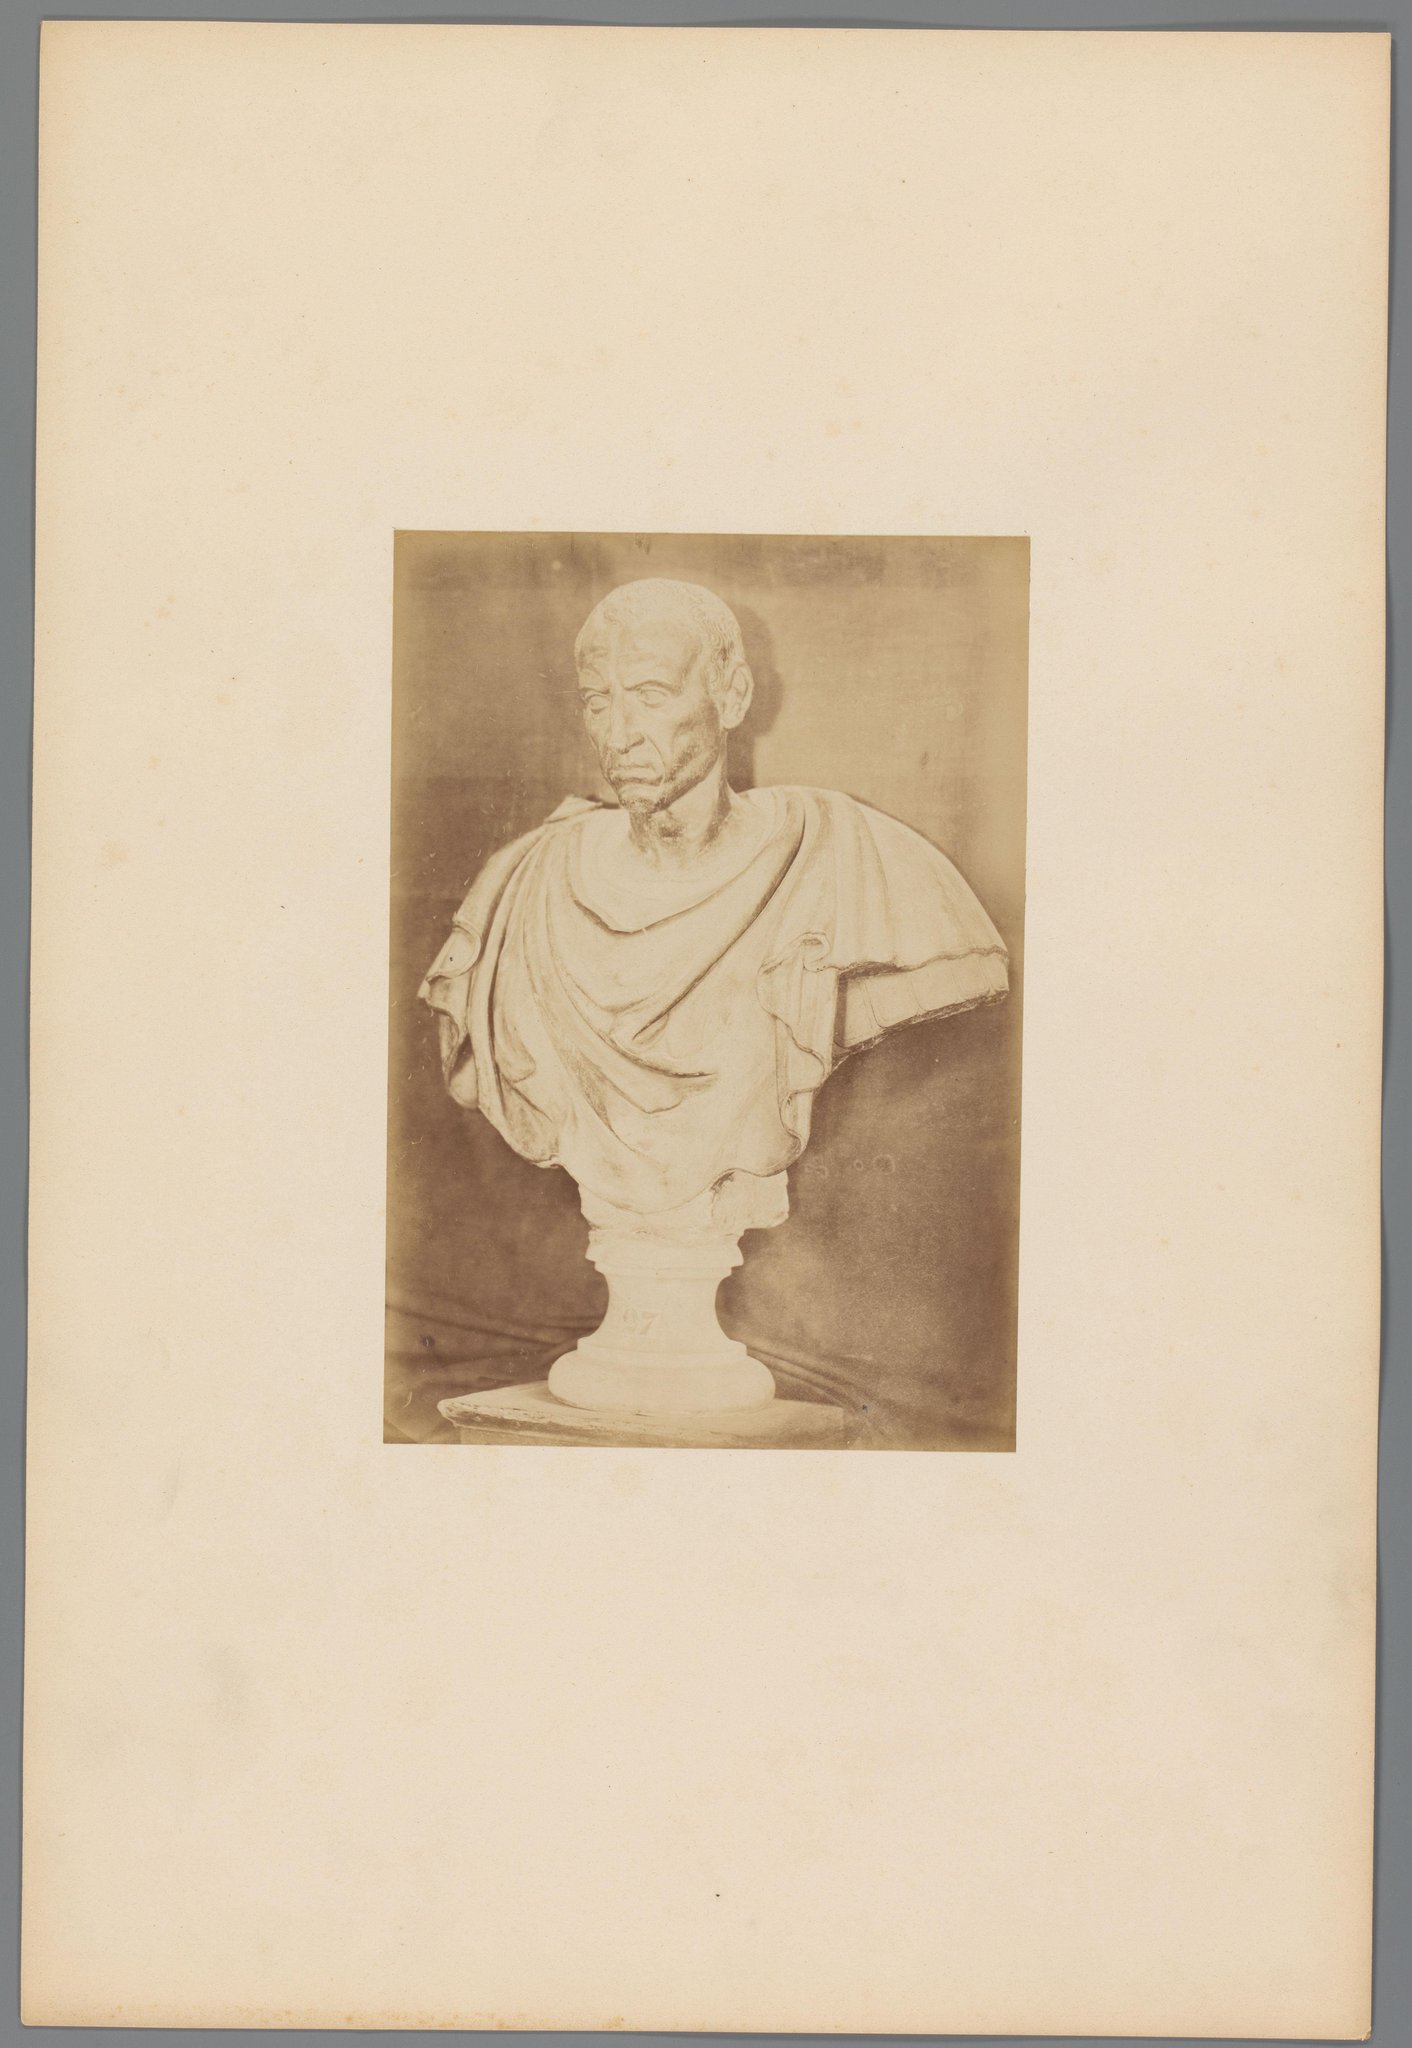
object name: photograph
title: Buste van een man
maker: Anonymous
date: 1851-1900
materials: cardboard, paper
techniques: albumen print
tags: head (human), piece of sculpture, reproduction of a piece of sculpture